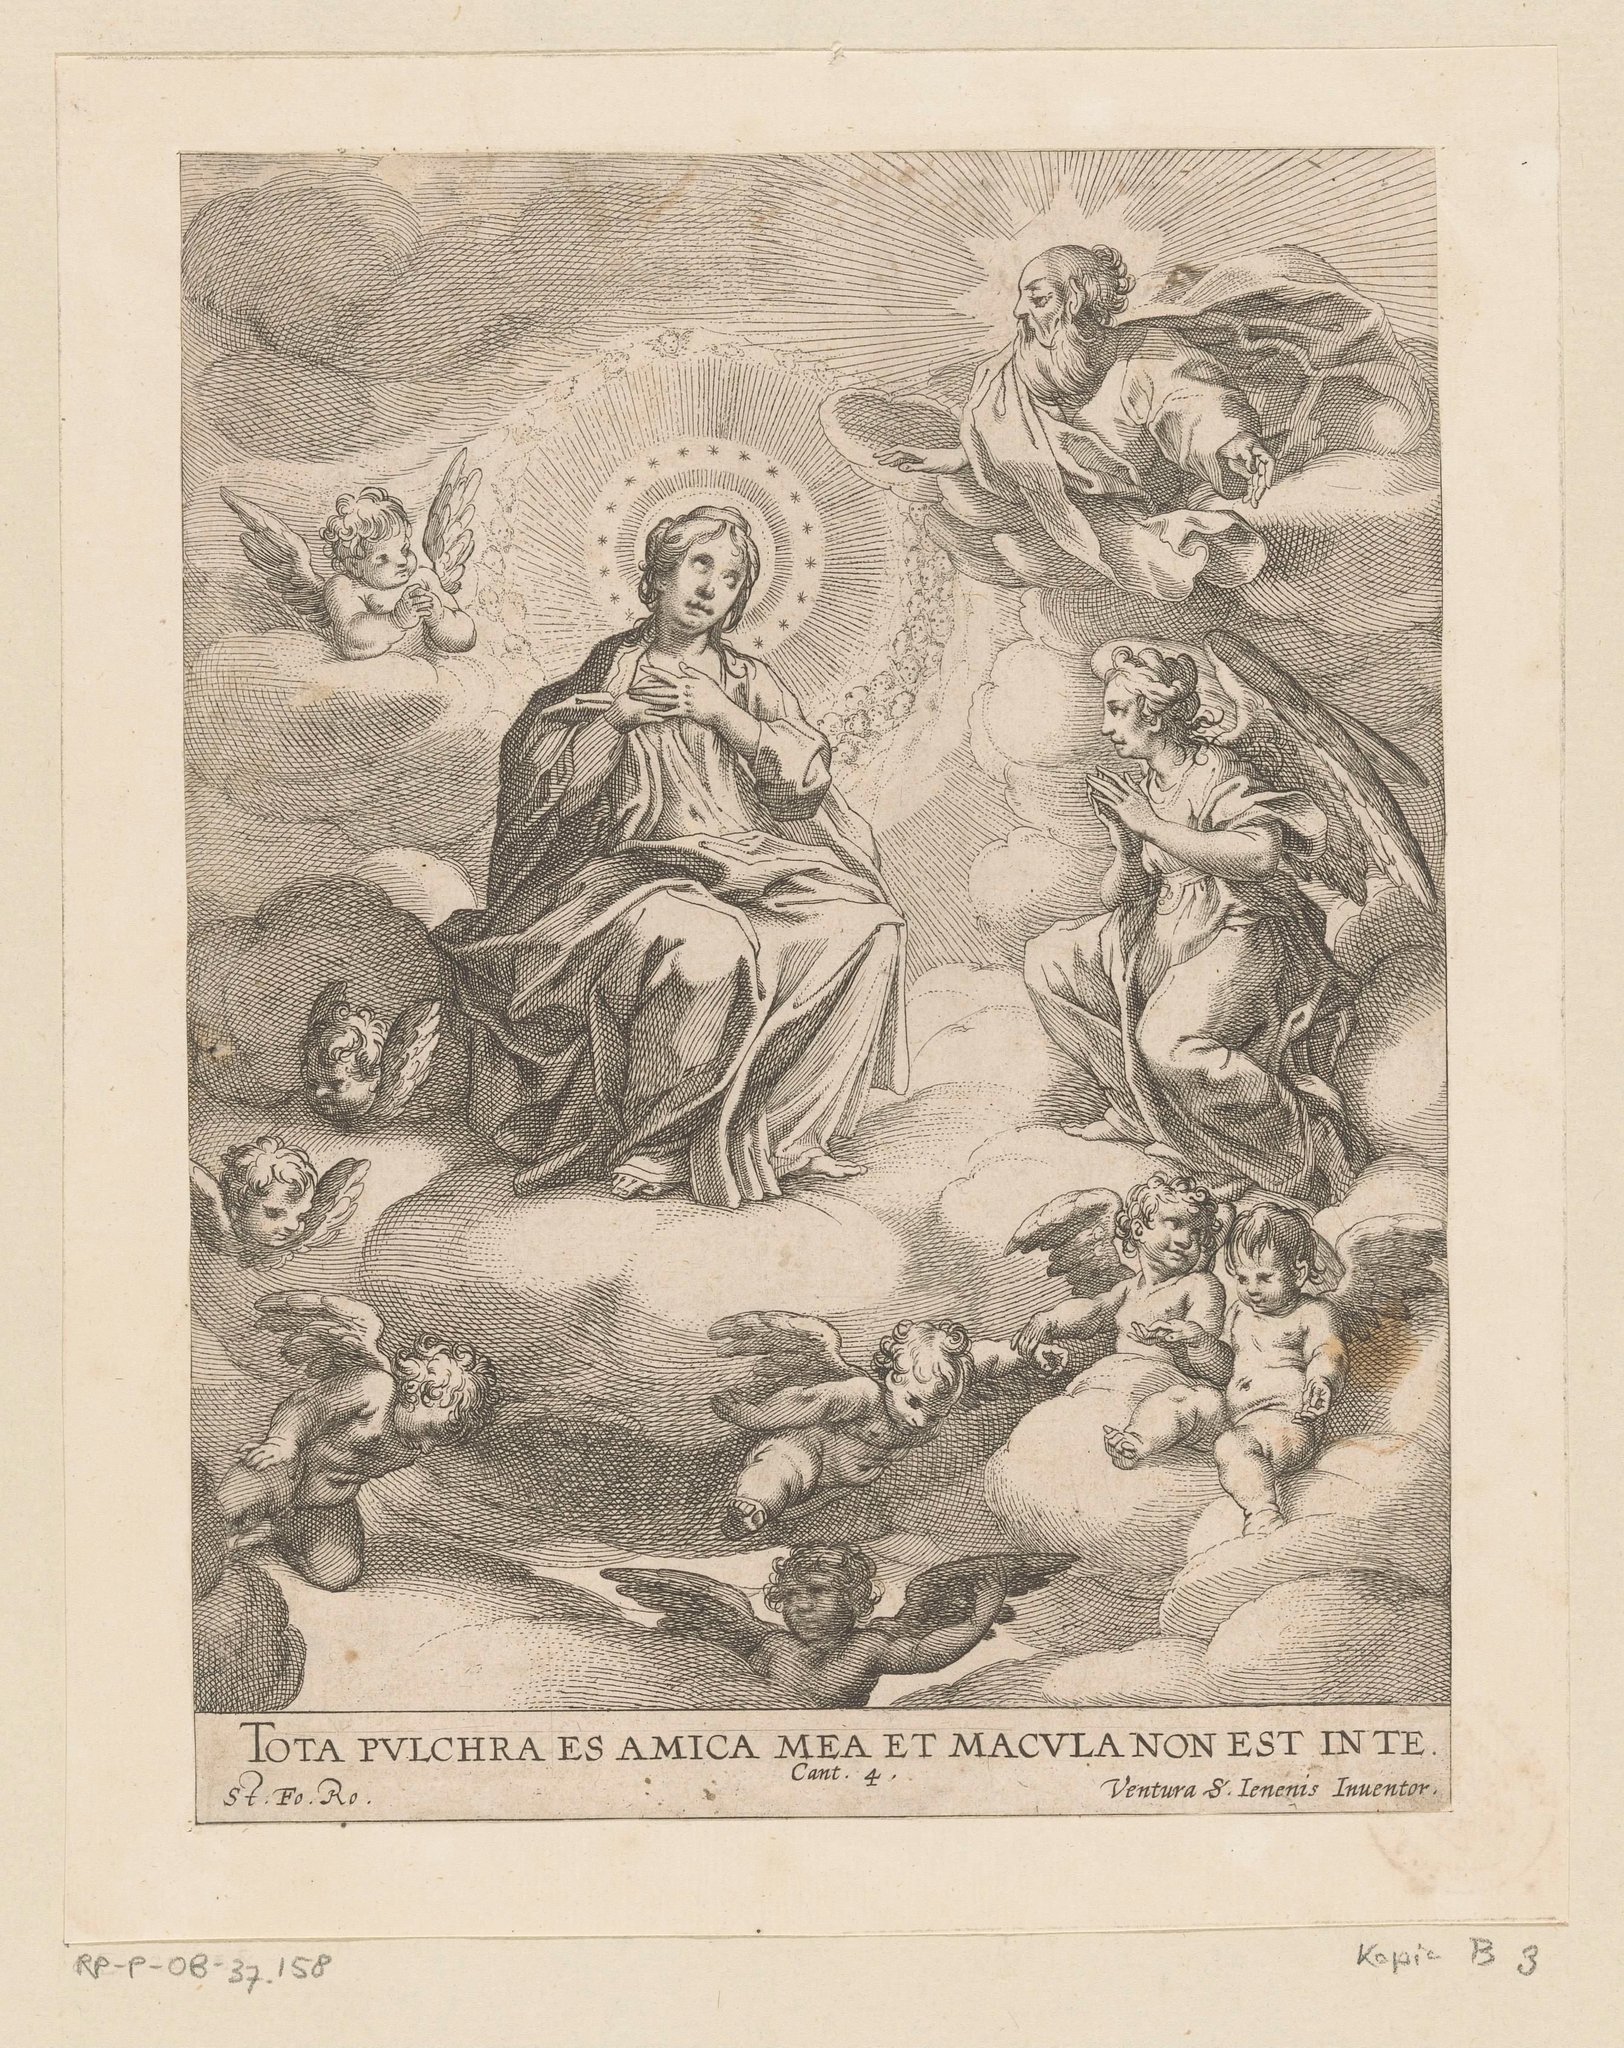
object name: print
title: Tota pulchra es amica mea et macula non est in te / Cant. 4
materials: paper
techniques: etching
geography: rome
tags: the virgin mary, god the father, cupids: 'amores', 'amoretti', 'putti', angels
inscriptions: collector's mark: Lugt 240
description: God de vader en engelen verschijnen aan de heilige Maagd Maria op wolken. Titel in het Latijn in ondermarge.